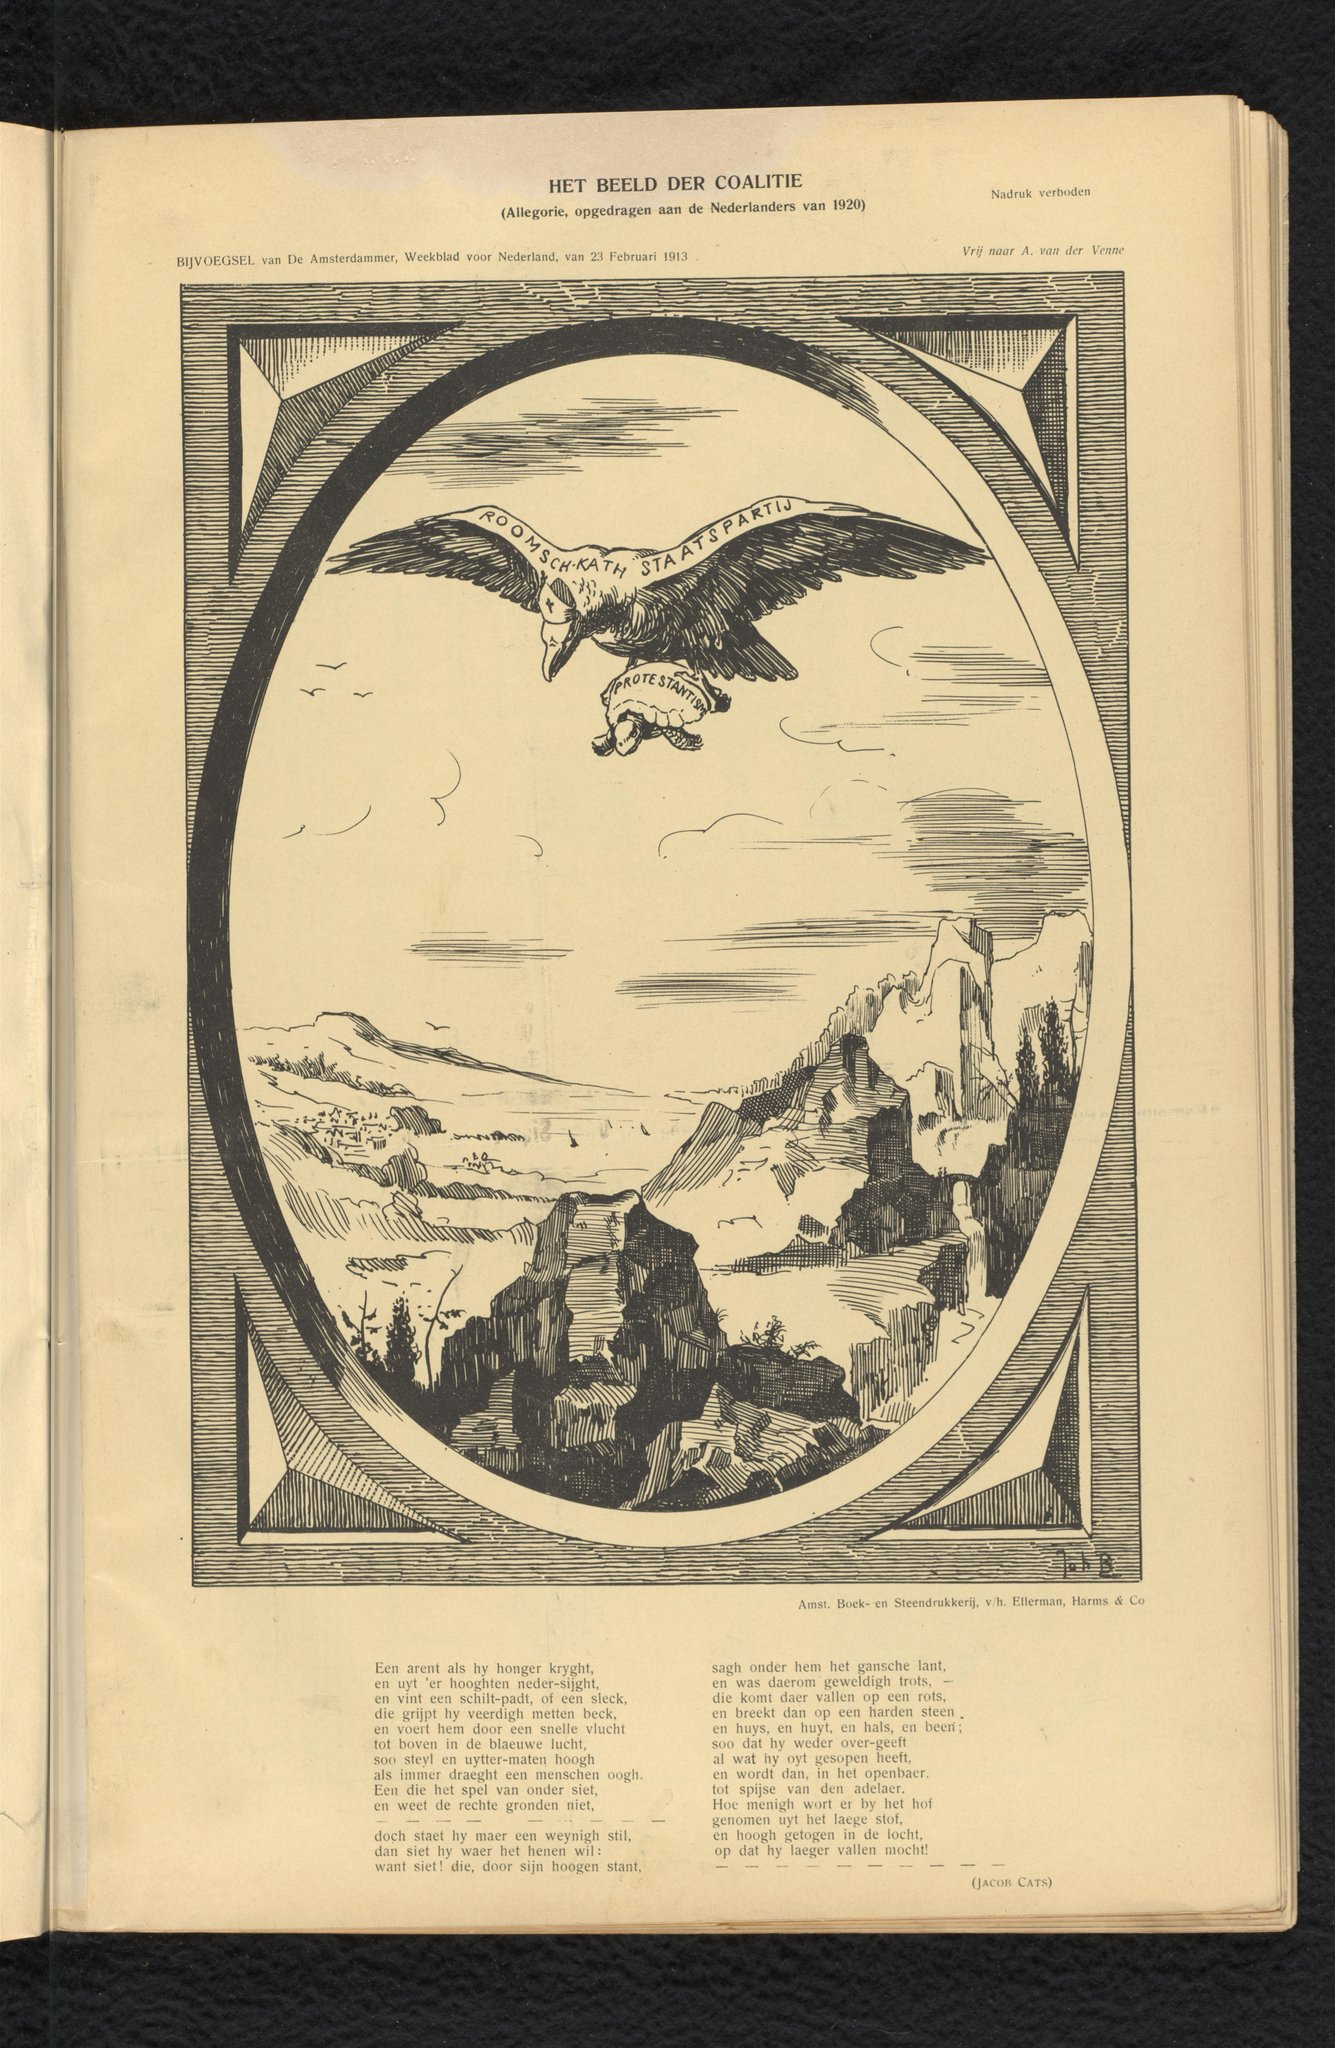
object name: cartoon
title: Het beeld der coalitie (Allegorie, opgedragen aan de Nederlanders van 1920)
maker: johan braakensiek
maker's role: draughtsman, print maker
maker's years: 1858-1940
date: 1913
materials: paper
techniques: lithograph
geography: netherlands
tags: tortoises, turtles, predatory birds: eagle, fables of aesop : use 85(...), political caricatures and satires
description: Pastiche op de fabel van de arend en de schildpad waarbij de arend de Roomsch-Katholieke Staatspartij is en de schildpad de Protestanten. Onder het embleem een vers van Jacob Cats in twee kolommen.